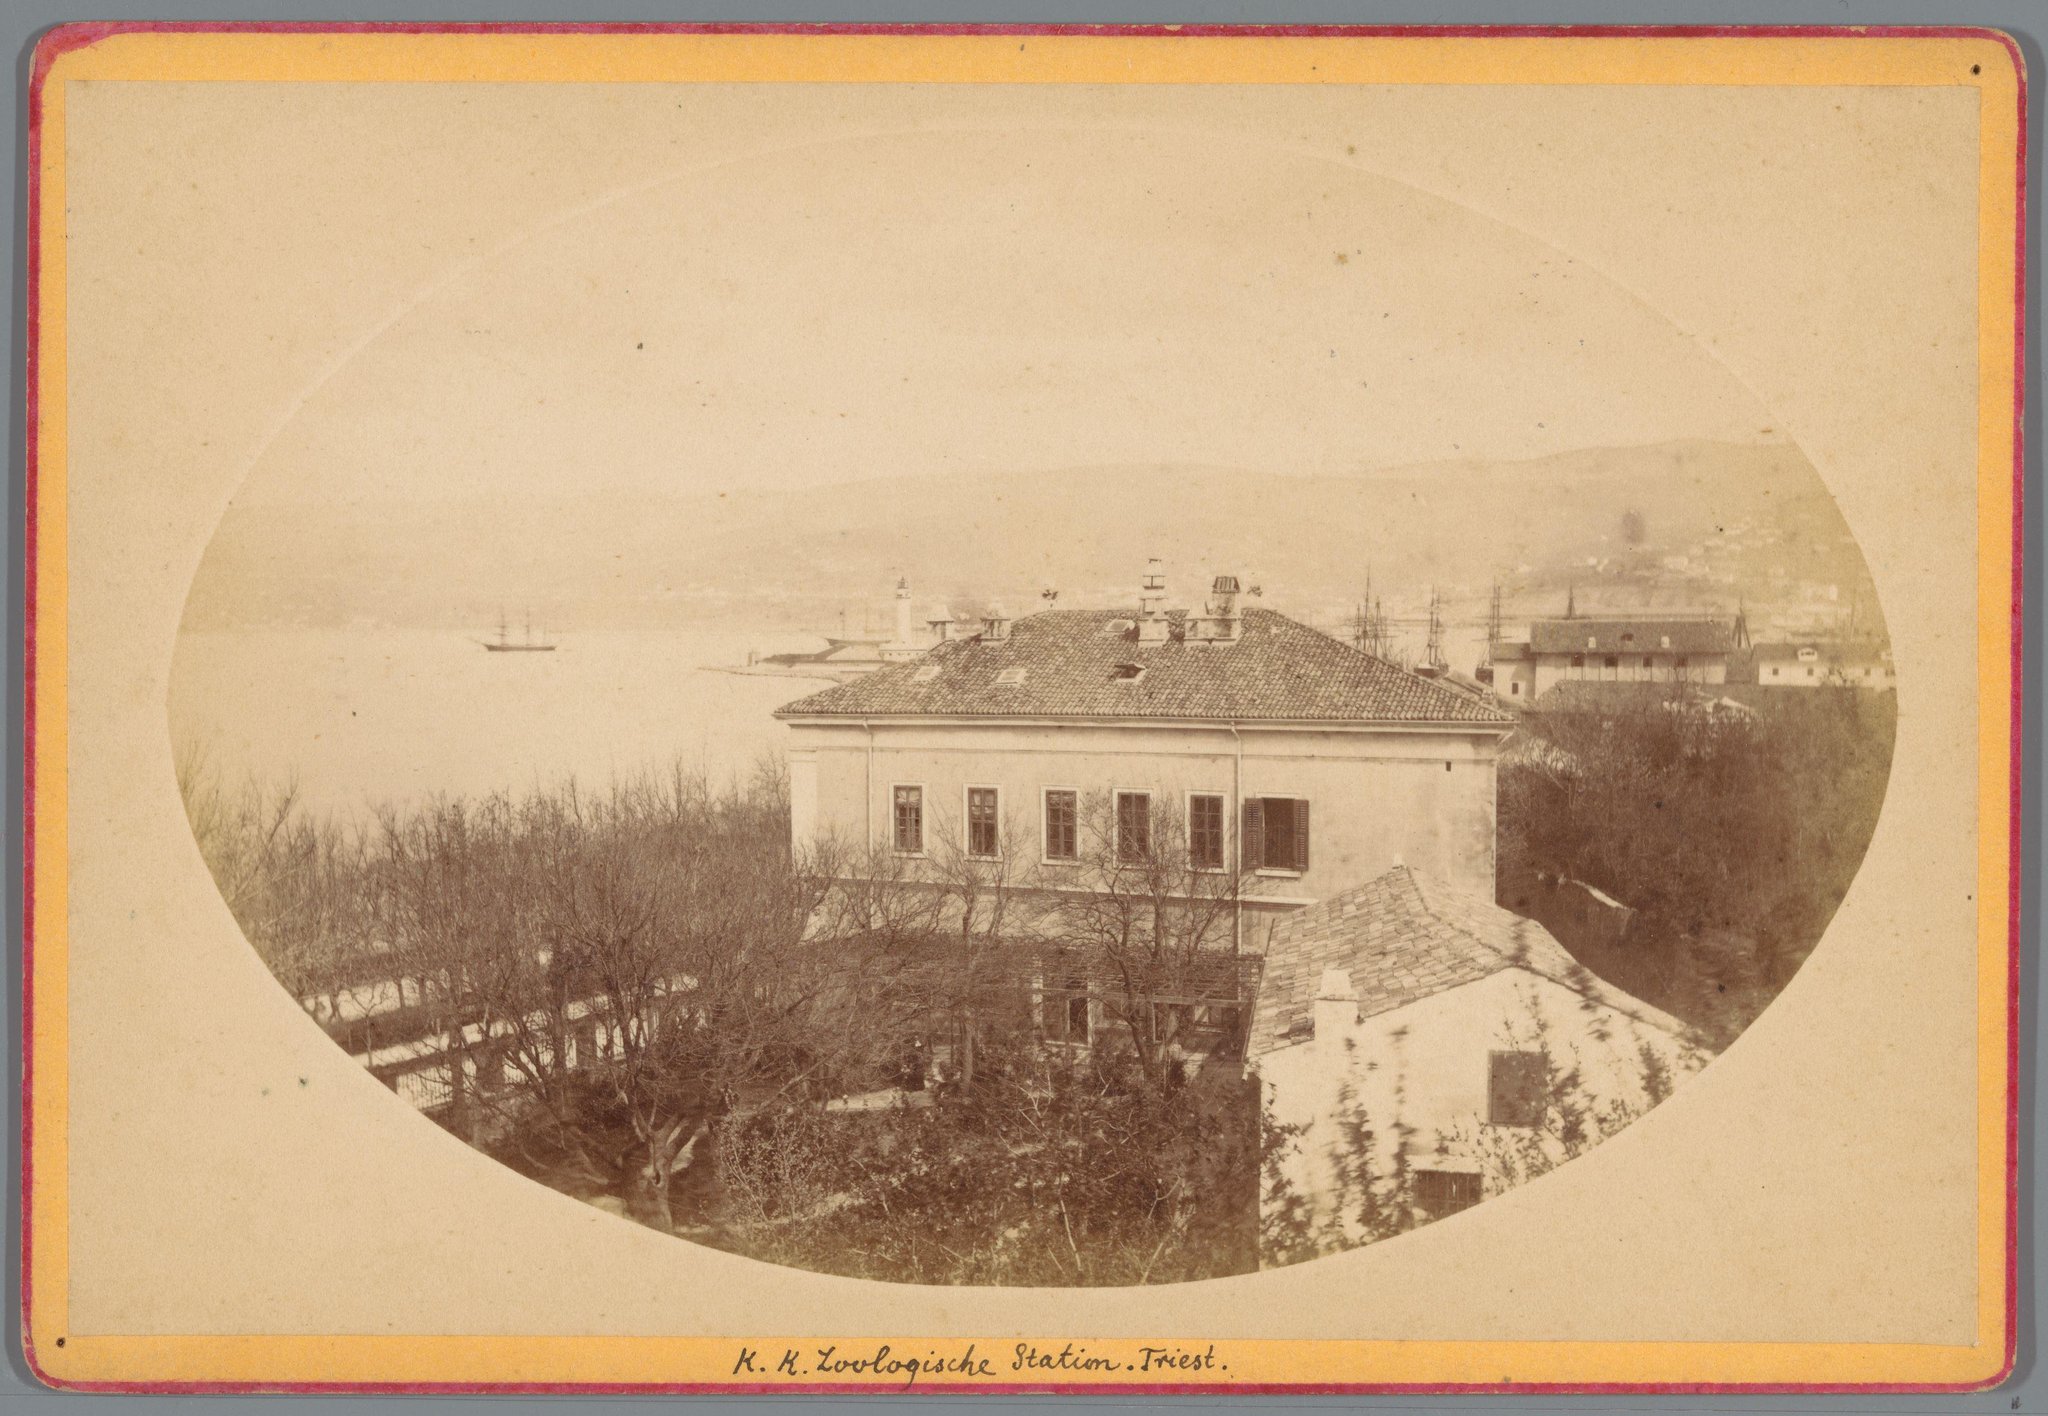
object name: cabinet photograph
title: K.K. Zoologische Station. Triest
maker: Anonymous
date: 1870-1890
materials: cardboard, photographic support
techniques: albumen print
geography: trieste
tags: university building, college, zoology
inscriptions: name: ‘Vosmaer’